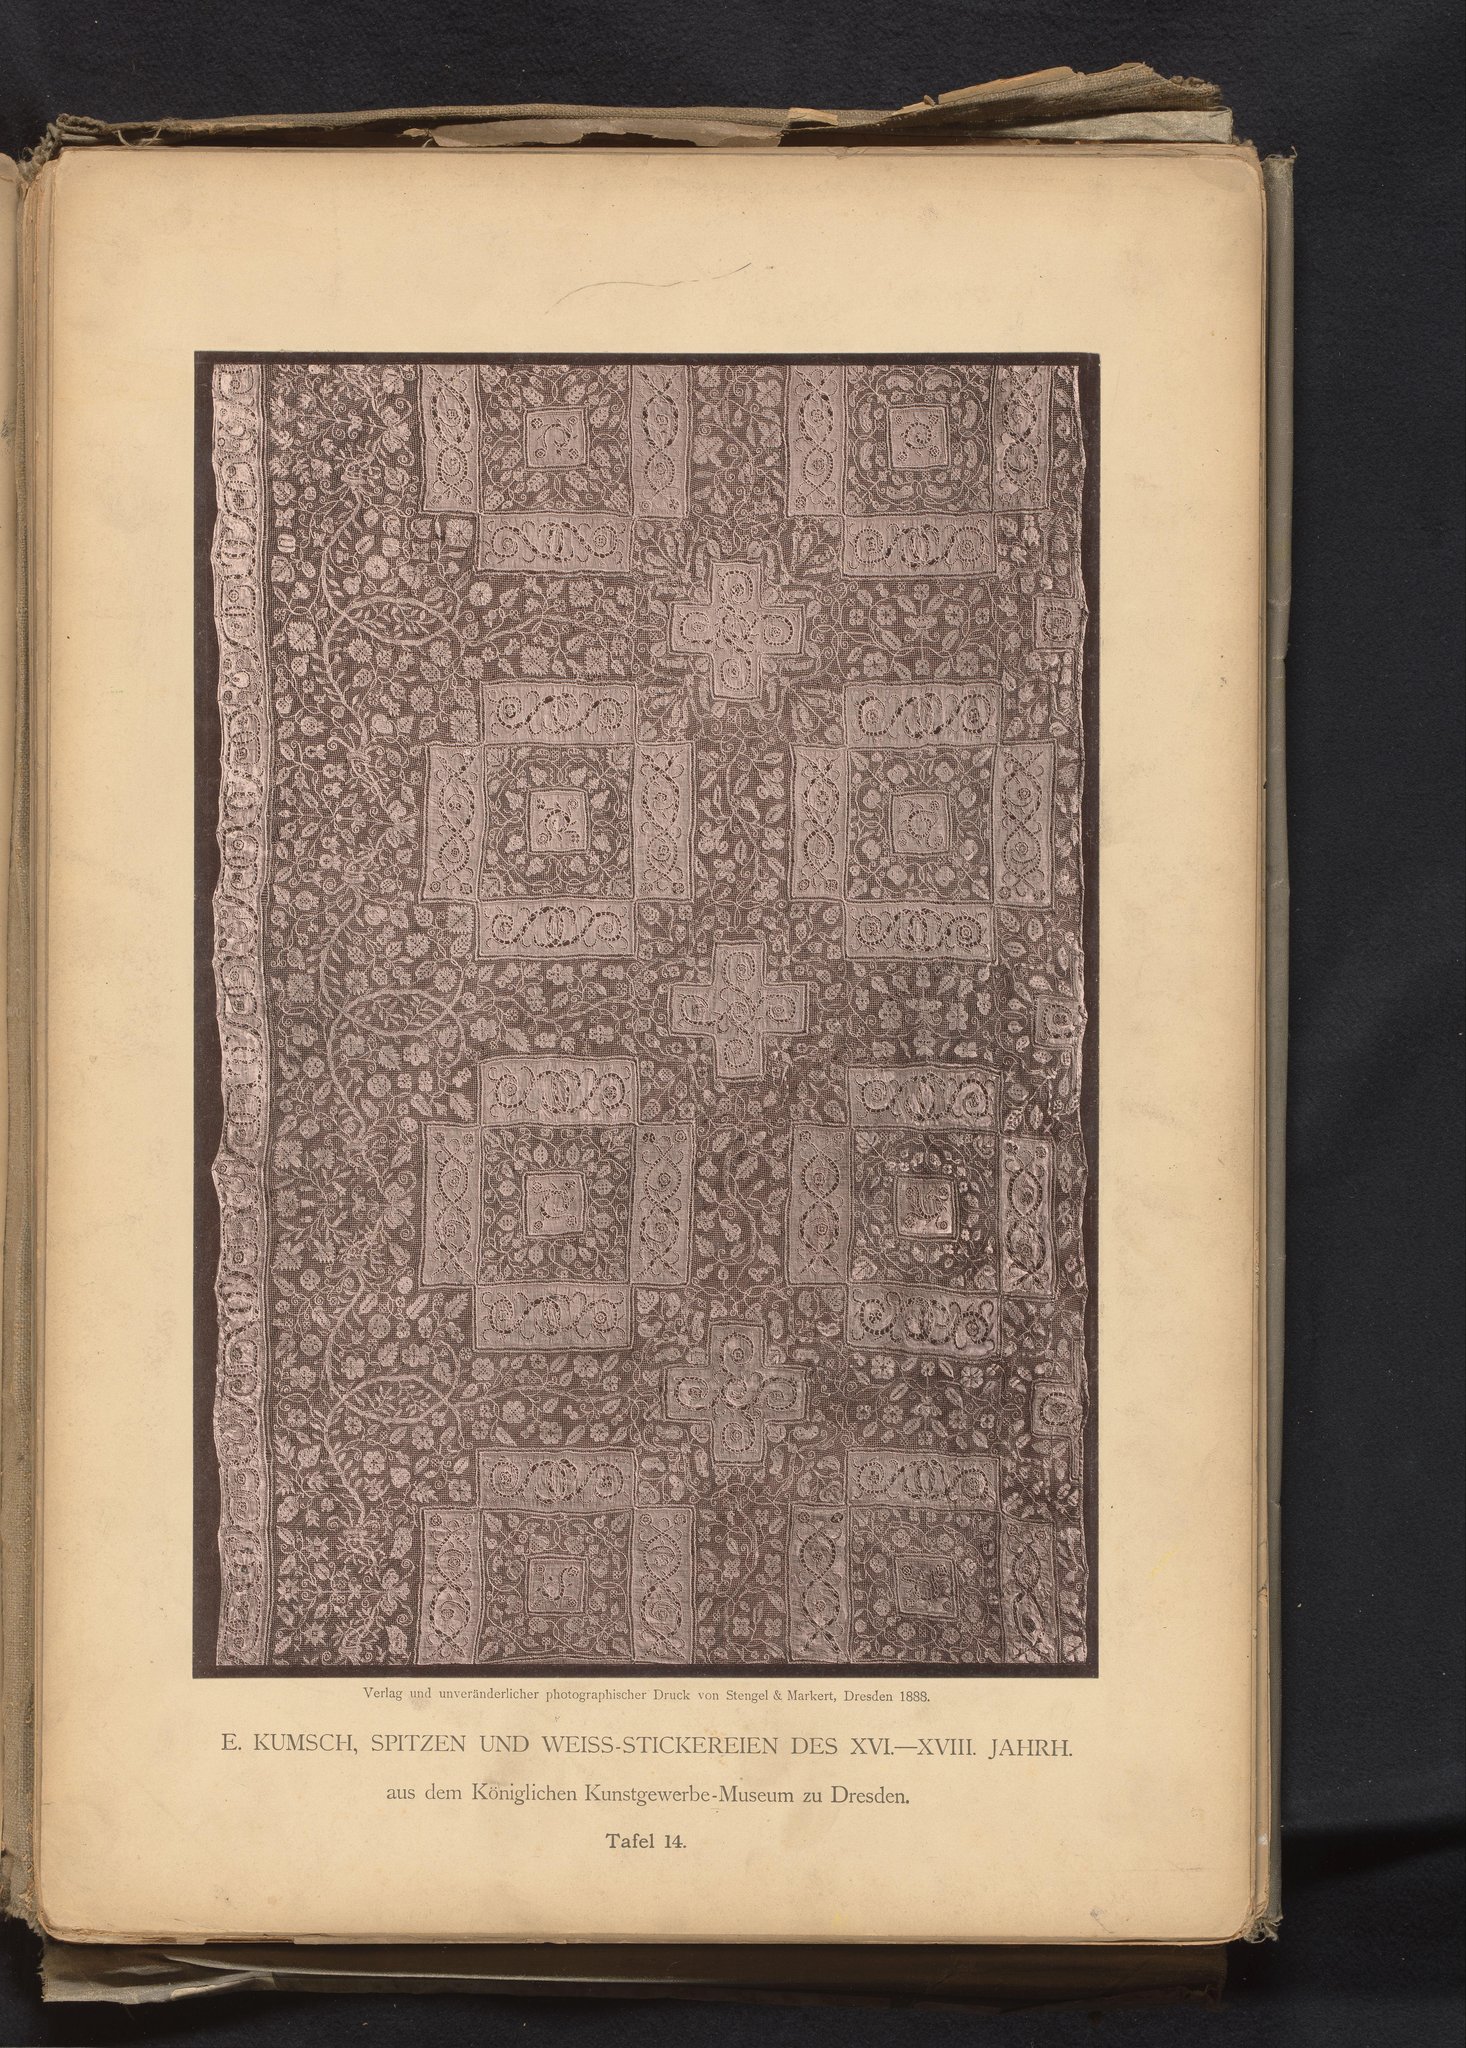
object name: photomechanical print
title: Brede strook 17de-eeuws Duits kant uit de collectie van het Kunstgewerbemuseum in Dresden, Duitsland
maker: Anonymous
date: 1888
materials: paper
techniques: photograph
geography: dresden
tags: lace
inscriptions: inscription: ‘E. KUMSCH, SPITZEN UND WEISS-STICKEREIEN DES XVI.-XVIII. JAHRH./ aus dem Königlichen Kunstgewerbe-Museum zu Dresden’, number: ‘Tafel 14.’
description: Deze prent maakt deel uit van een omslag met 49 prenten en een lijst van afbeeldingen.